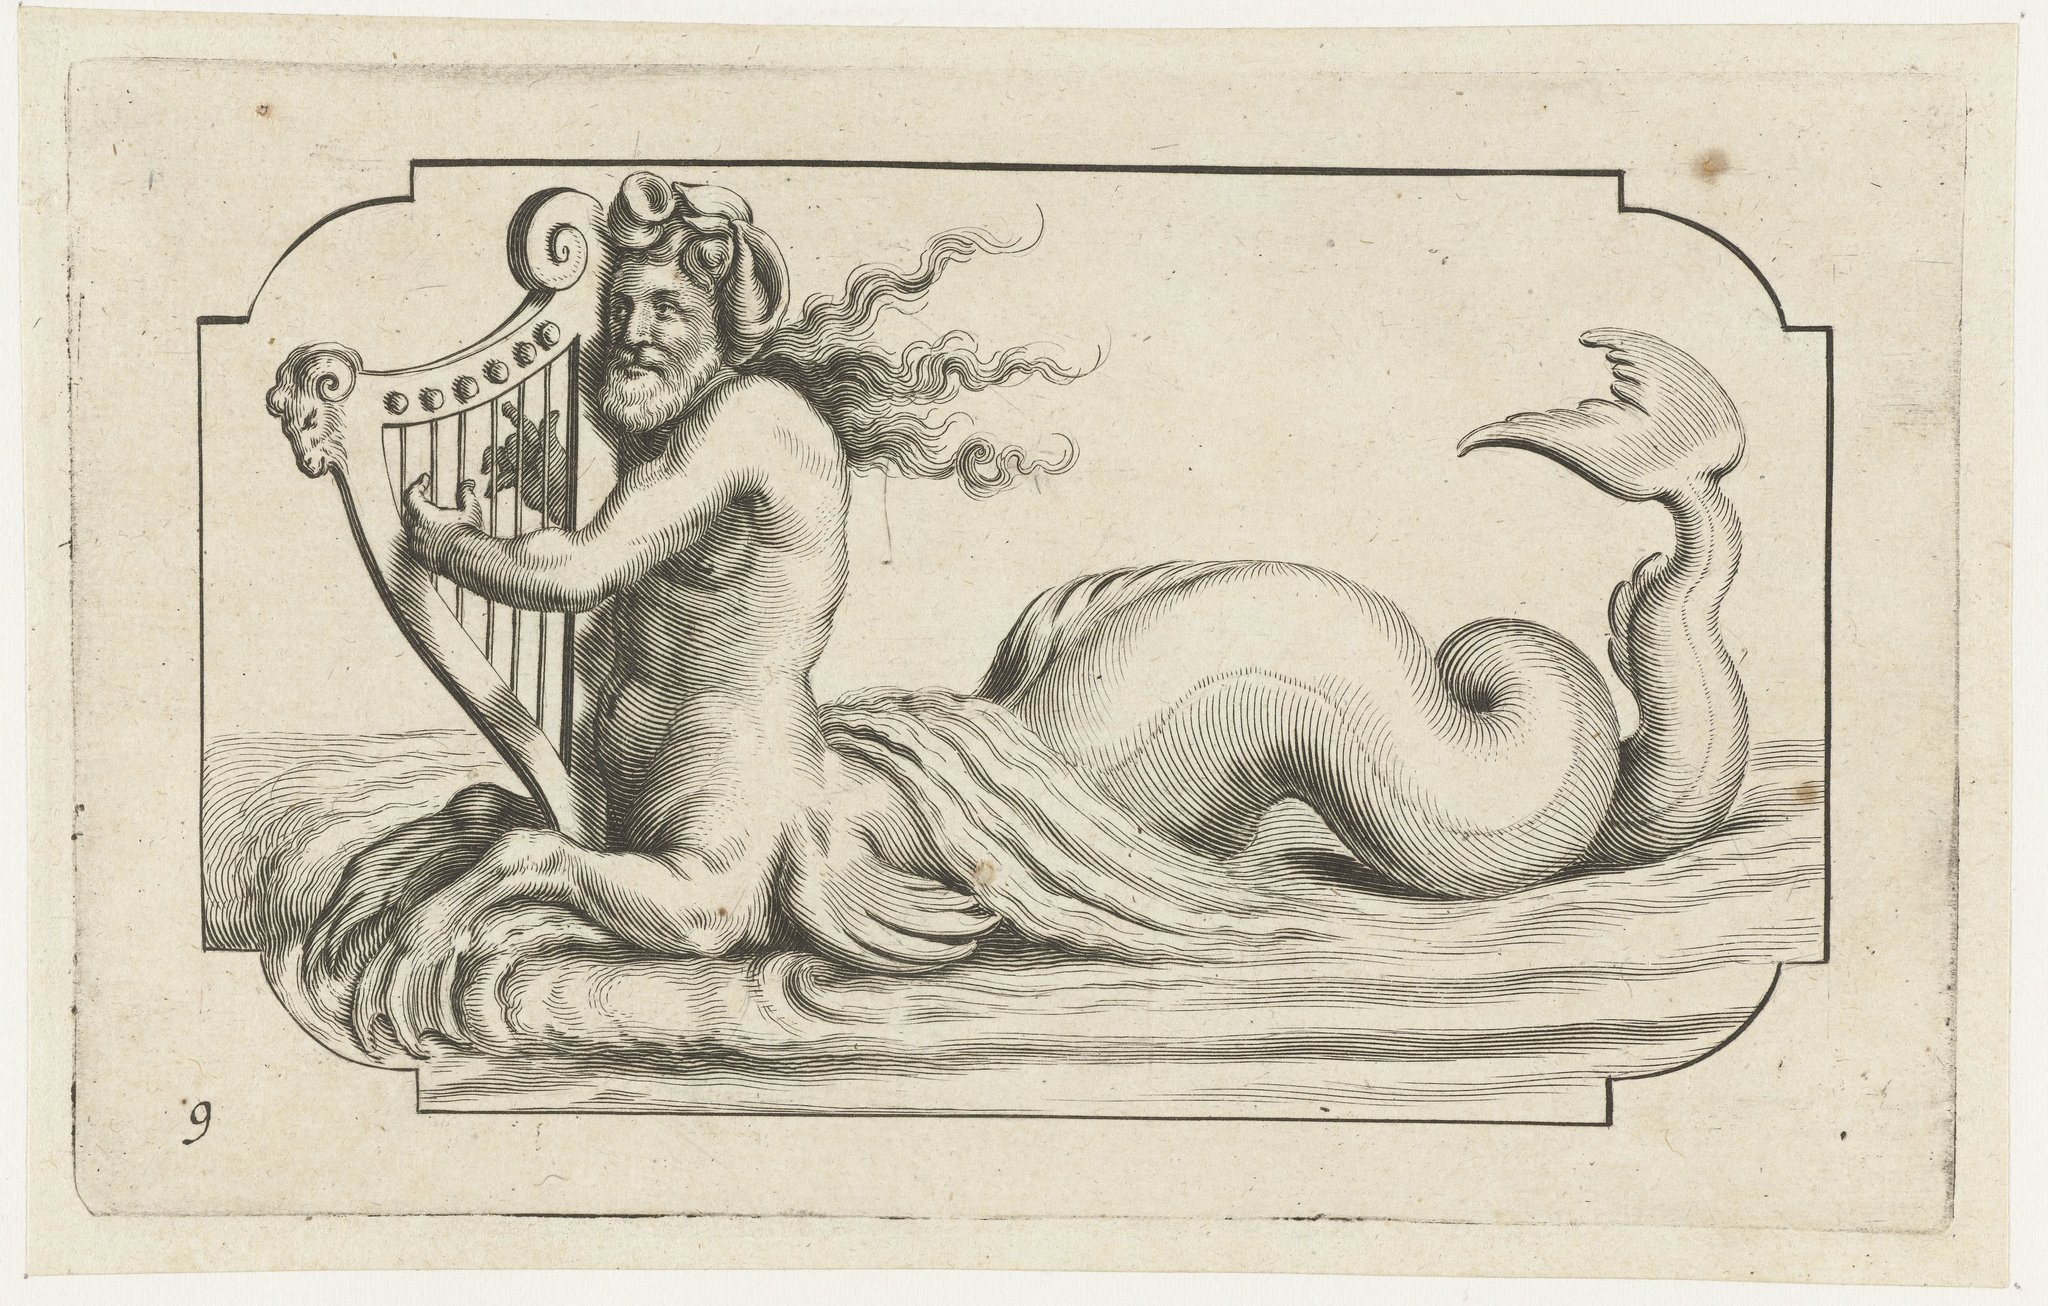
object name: print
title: Nouveau Livre des Dieux et Deeßes De la Marine Bouckje van Zeegoden en Godinnen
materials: paper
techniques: engraving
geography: amsterdam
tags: triton(s), harp